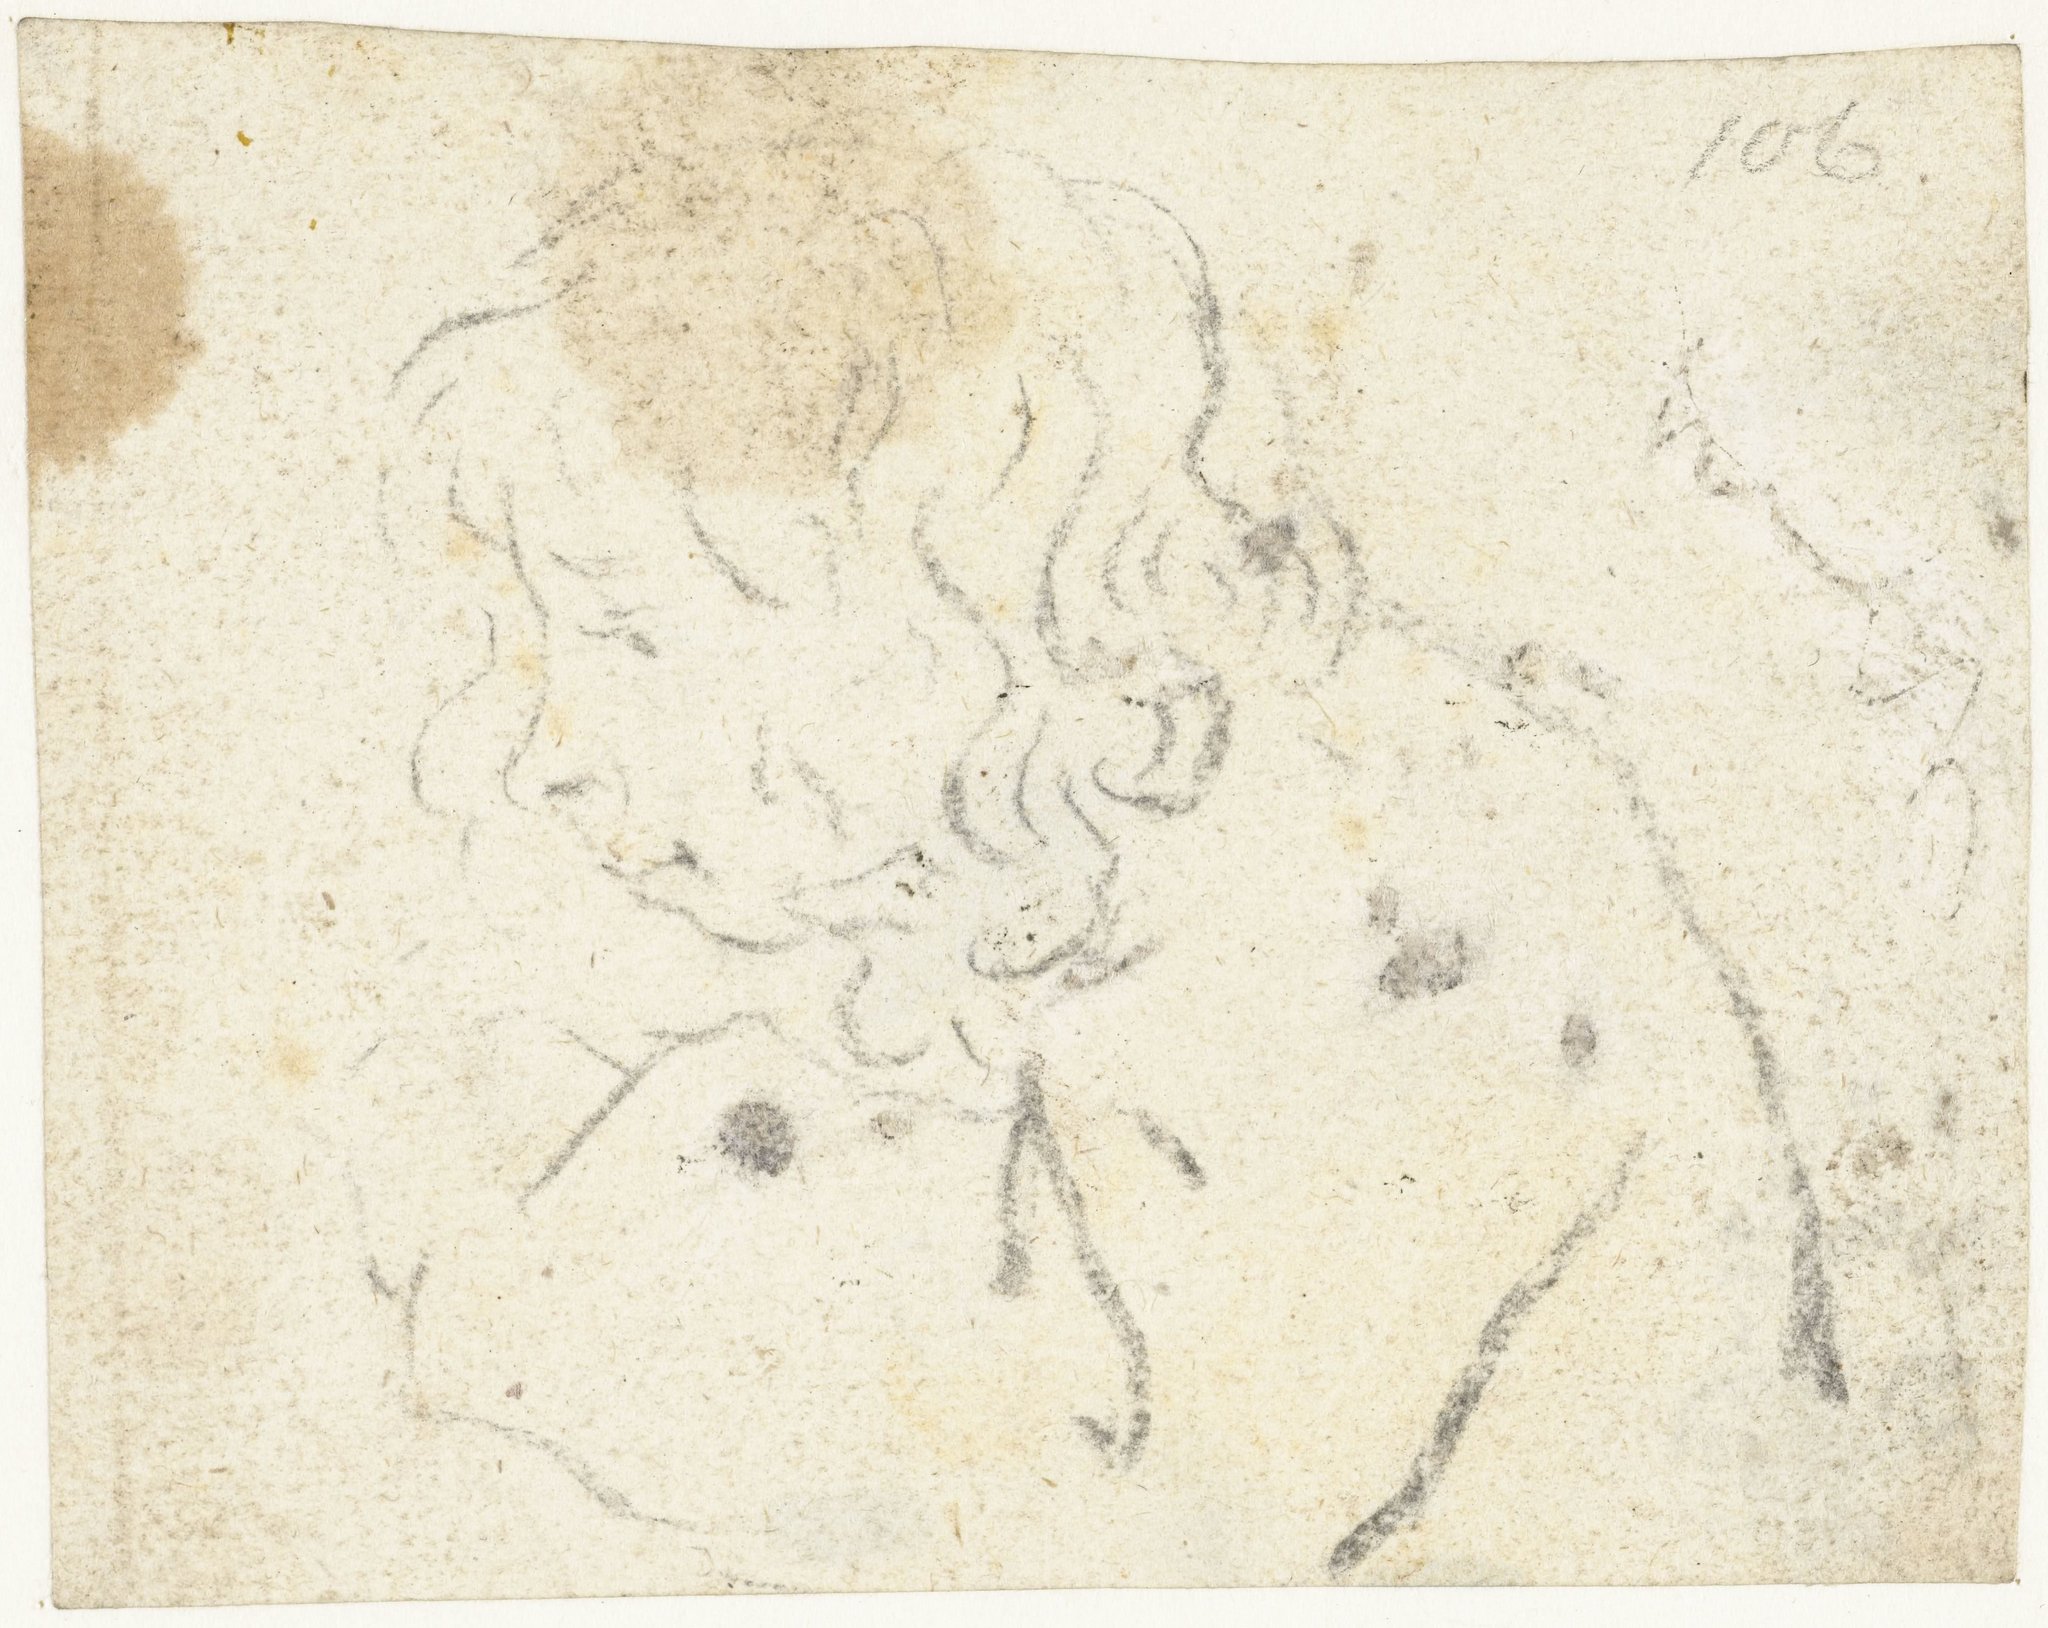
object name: drawing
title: Schets van Moses ter Borch, in profiel naar links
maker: gerard ter borch (ii)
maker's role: draughtsman, painter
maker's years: 1617-1681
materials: chalk, paper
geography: zwolle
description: Kopie naar de tekening van Gerard de Jonge, GJr 79.